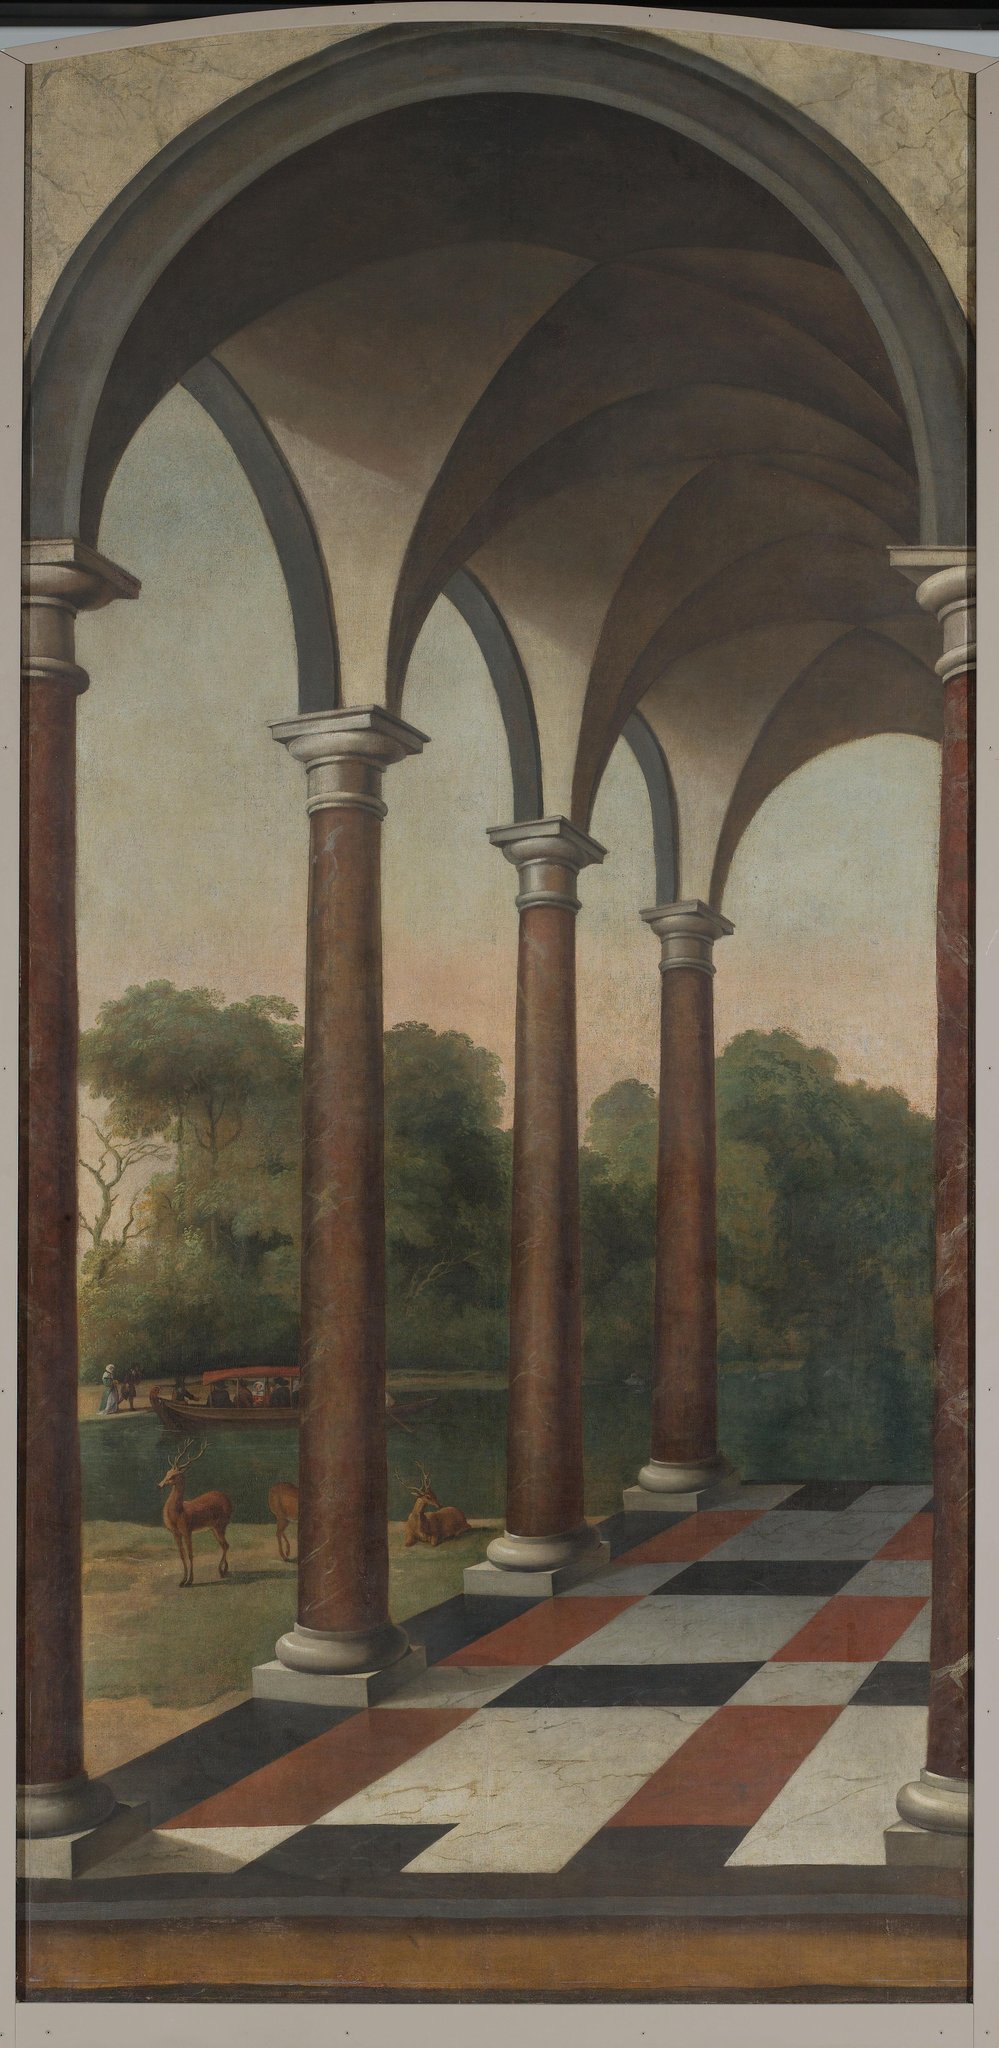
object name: painting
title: Colonnade giving onto a Park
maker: barent fabritius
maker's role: draughtsman, painter, print maker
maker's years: 1624-1673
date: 1660-1673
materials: canvas, oil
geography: northern netherlands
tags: park, colonnade, garden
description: Zuilengalerij met uitzicht op een park. In de tuin zijn drie herten, op de achtergrond meert een bootje met passagiers aan. Met geïntegreerde lijst.